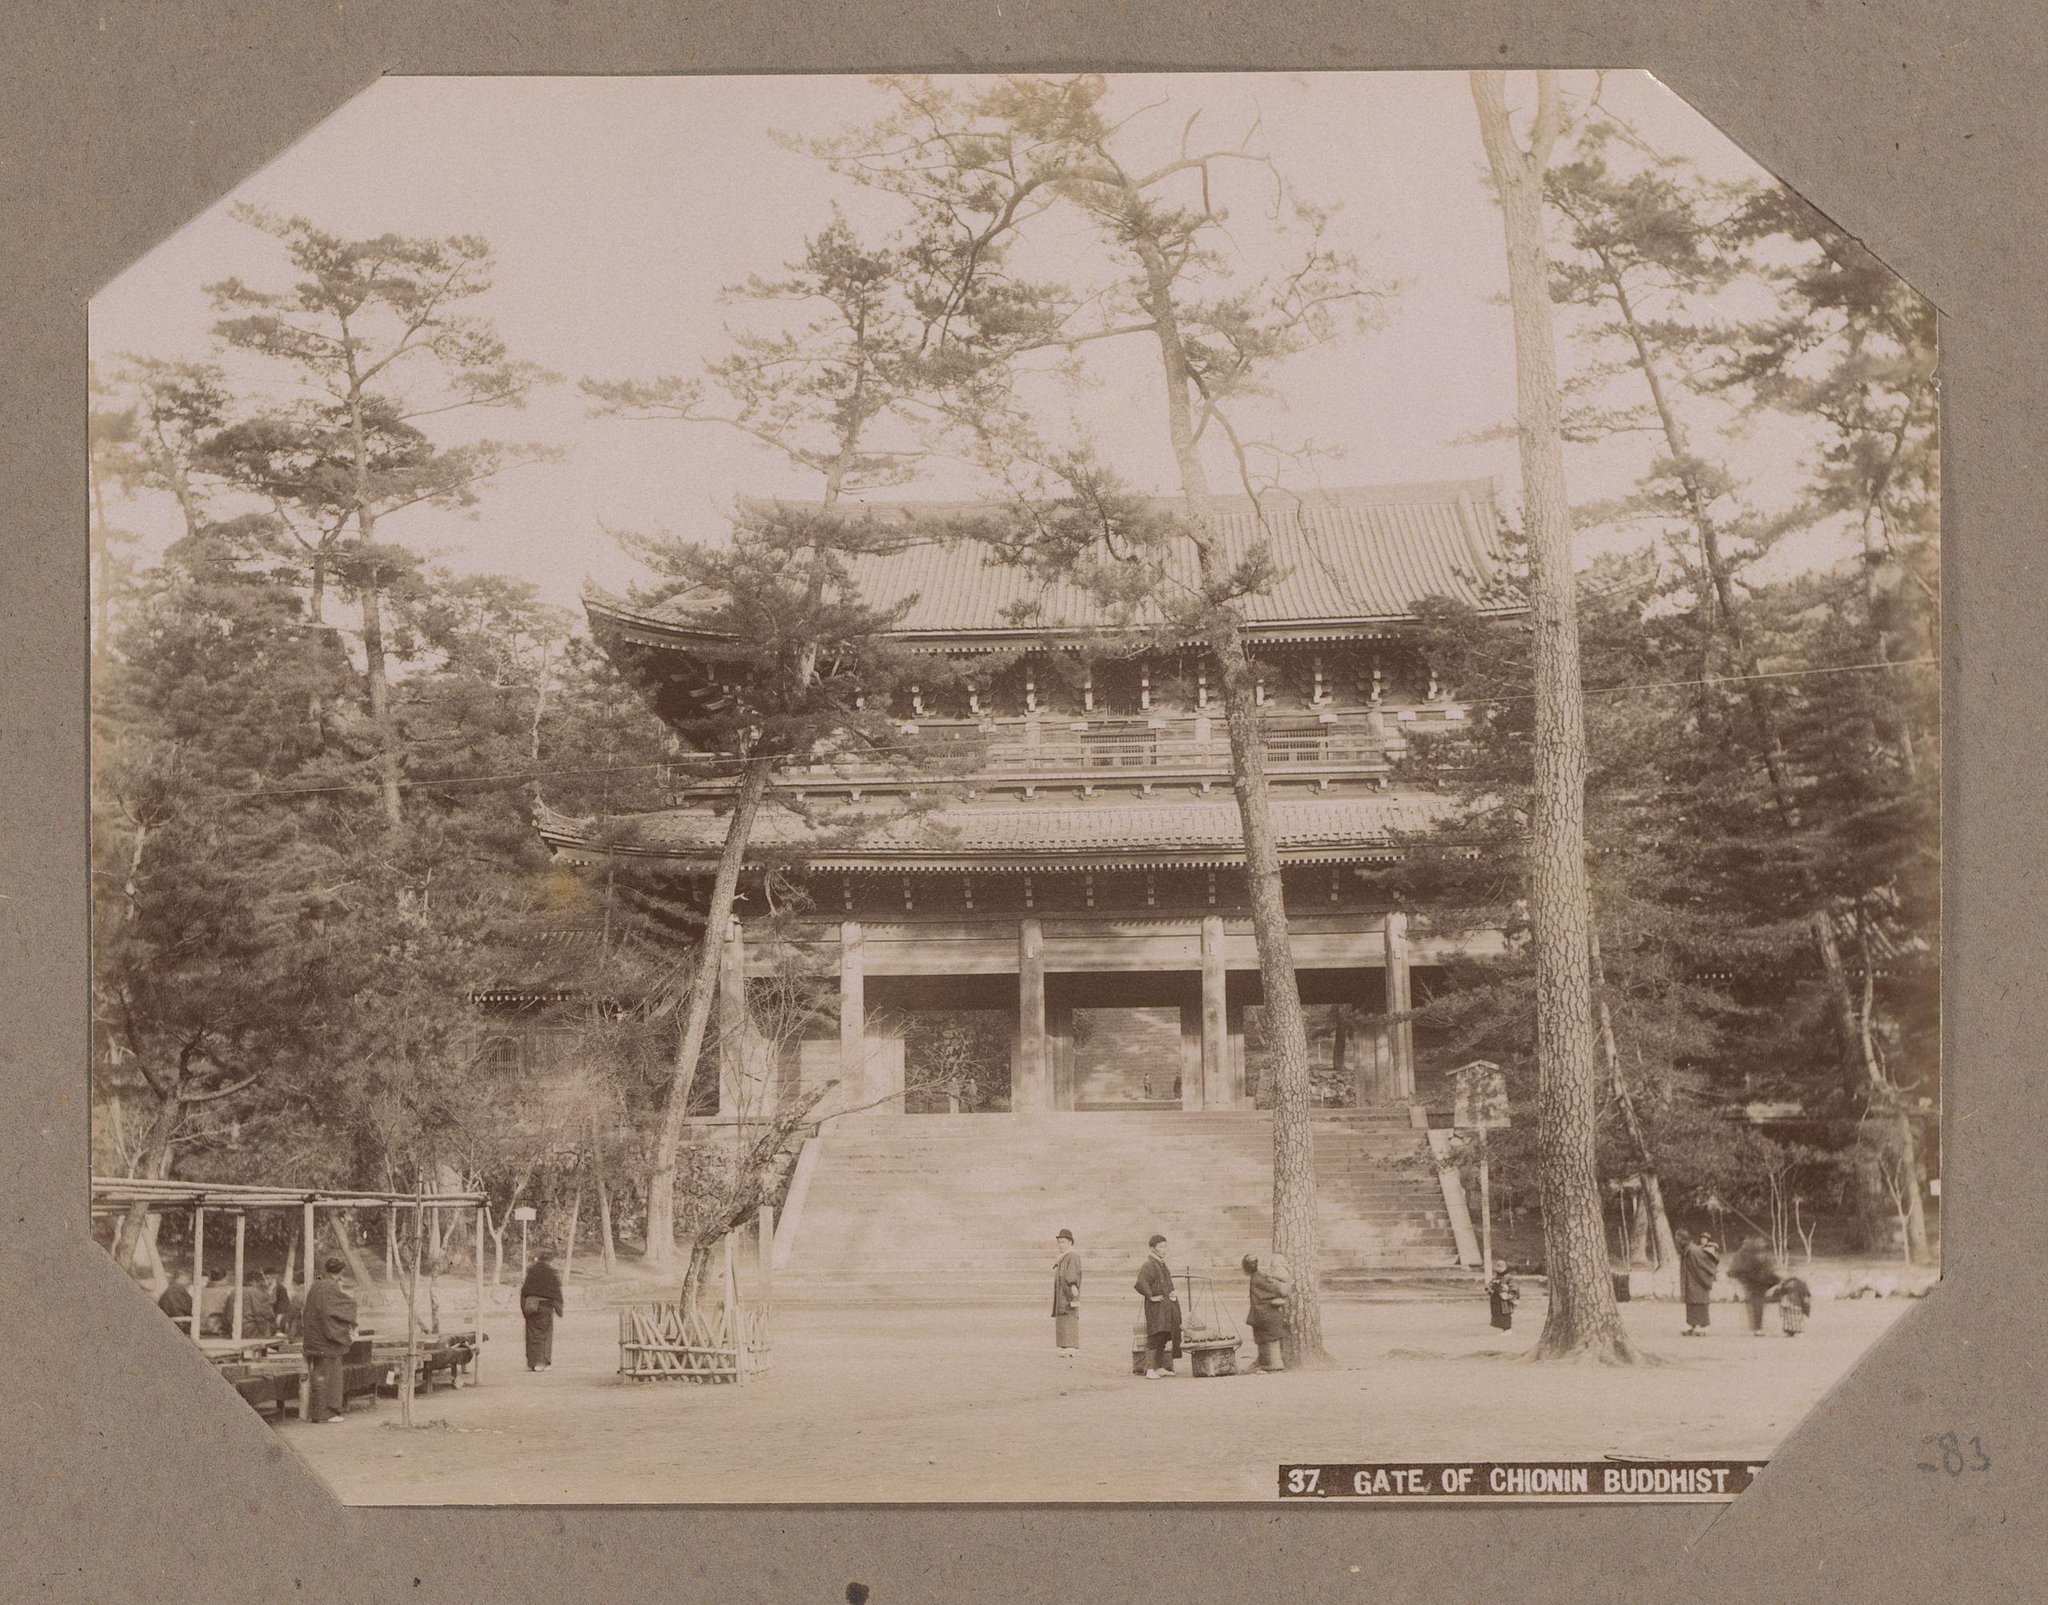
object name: photograph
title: Gezicht op de poort van de Chion-in tempel in Kyoto, Japan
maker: Anonymous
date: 1890-1903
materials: paper, photographic support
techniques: albumen print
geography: kyoto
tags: temple, shrine ~ hinduism, buddhism, jainism, gate, entrance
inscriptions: inscription: ‘37. Gate of Chionin Buddhist Temple. - Kiot[o]’